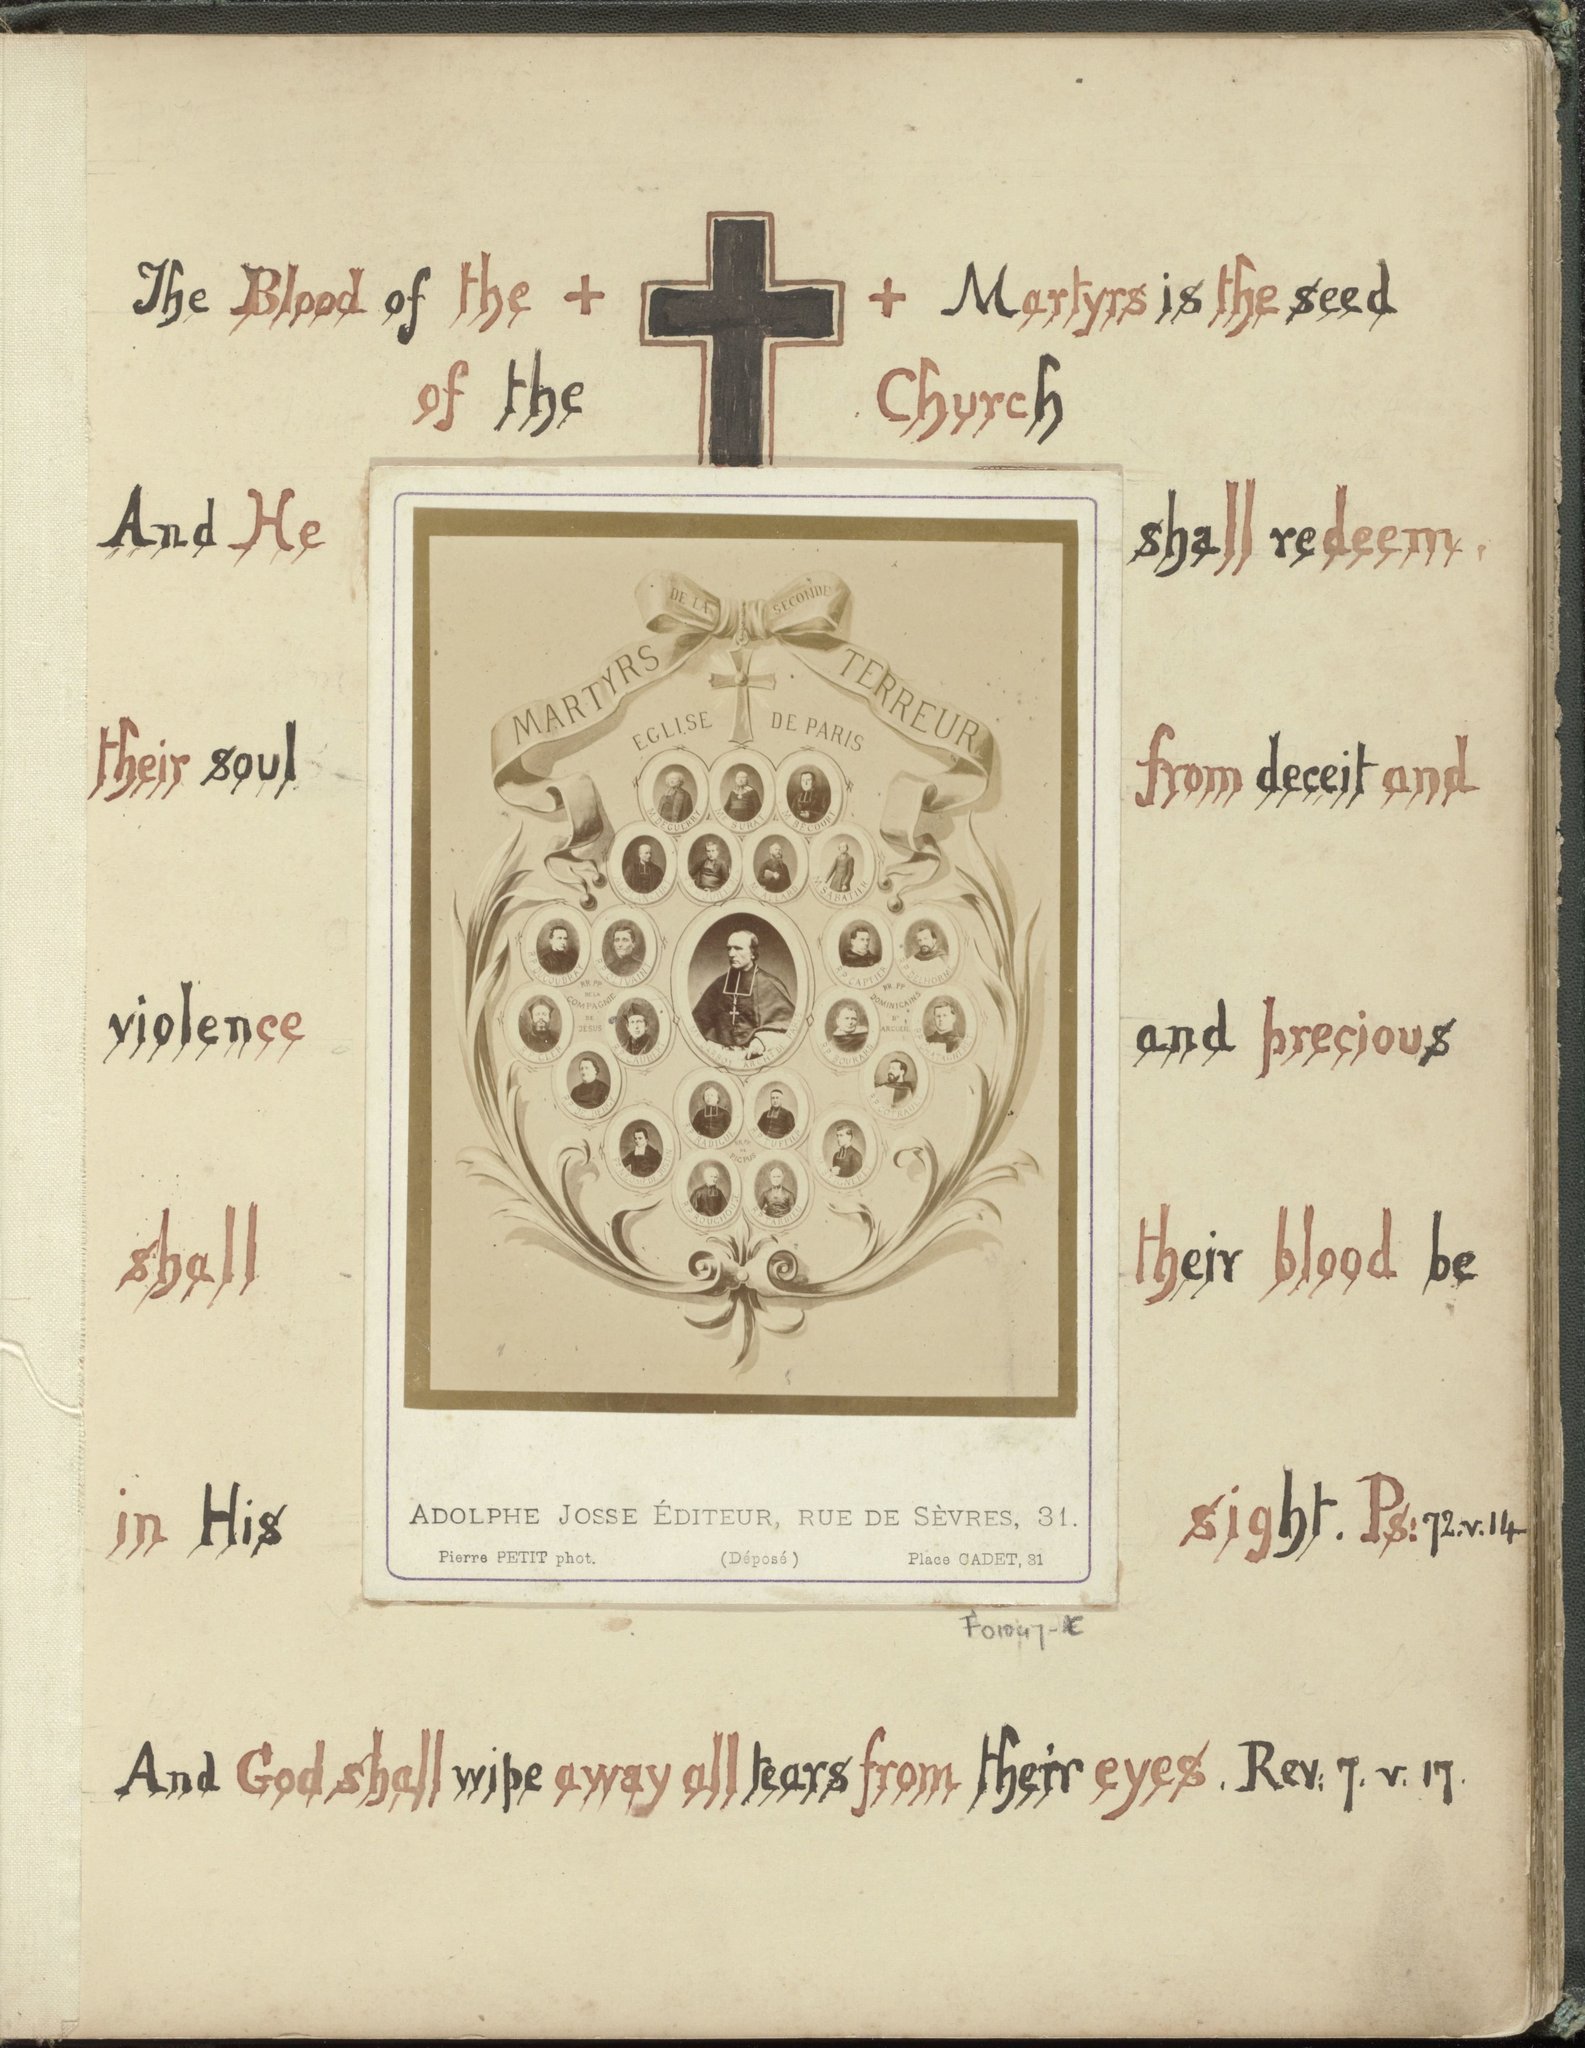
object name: photograph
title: Martyrs de la seconde Terreur, Eglise de Paris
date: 1871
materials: cardboard, paper, photographic support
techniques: albumen print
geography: paris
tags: priest (roman catholic), violent death, being killed; being mishandled and maltreated; seeking death - ee - death not certain; wounded person, paris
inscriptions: address: ‘Rue de Sèvres 31, Place Cadet, 31’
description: Onderdeel van Herdenkingsalbum van rooms-katholieke geestelijken gevallen tijdens de Commune van Parijs.